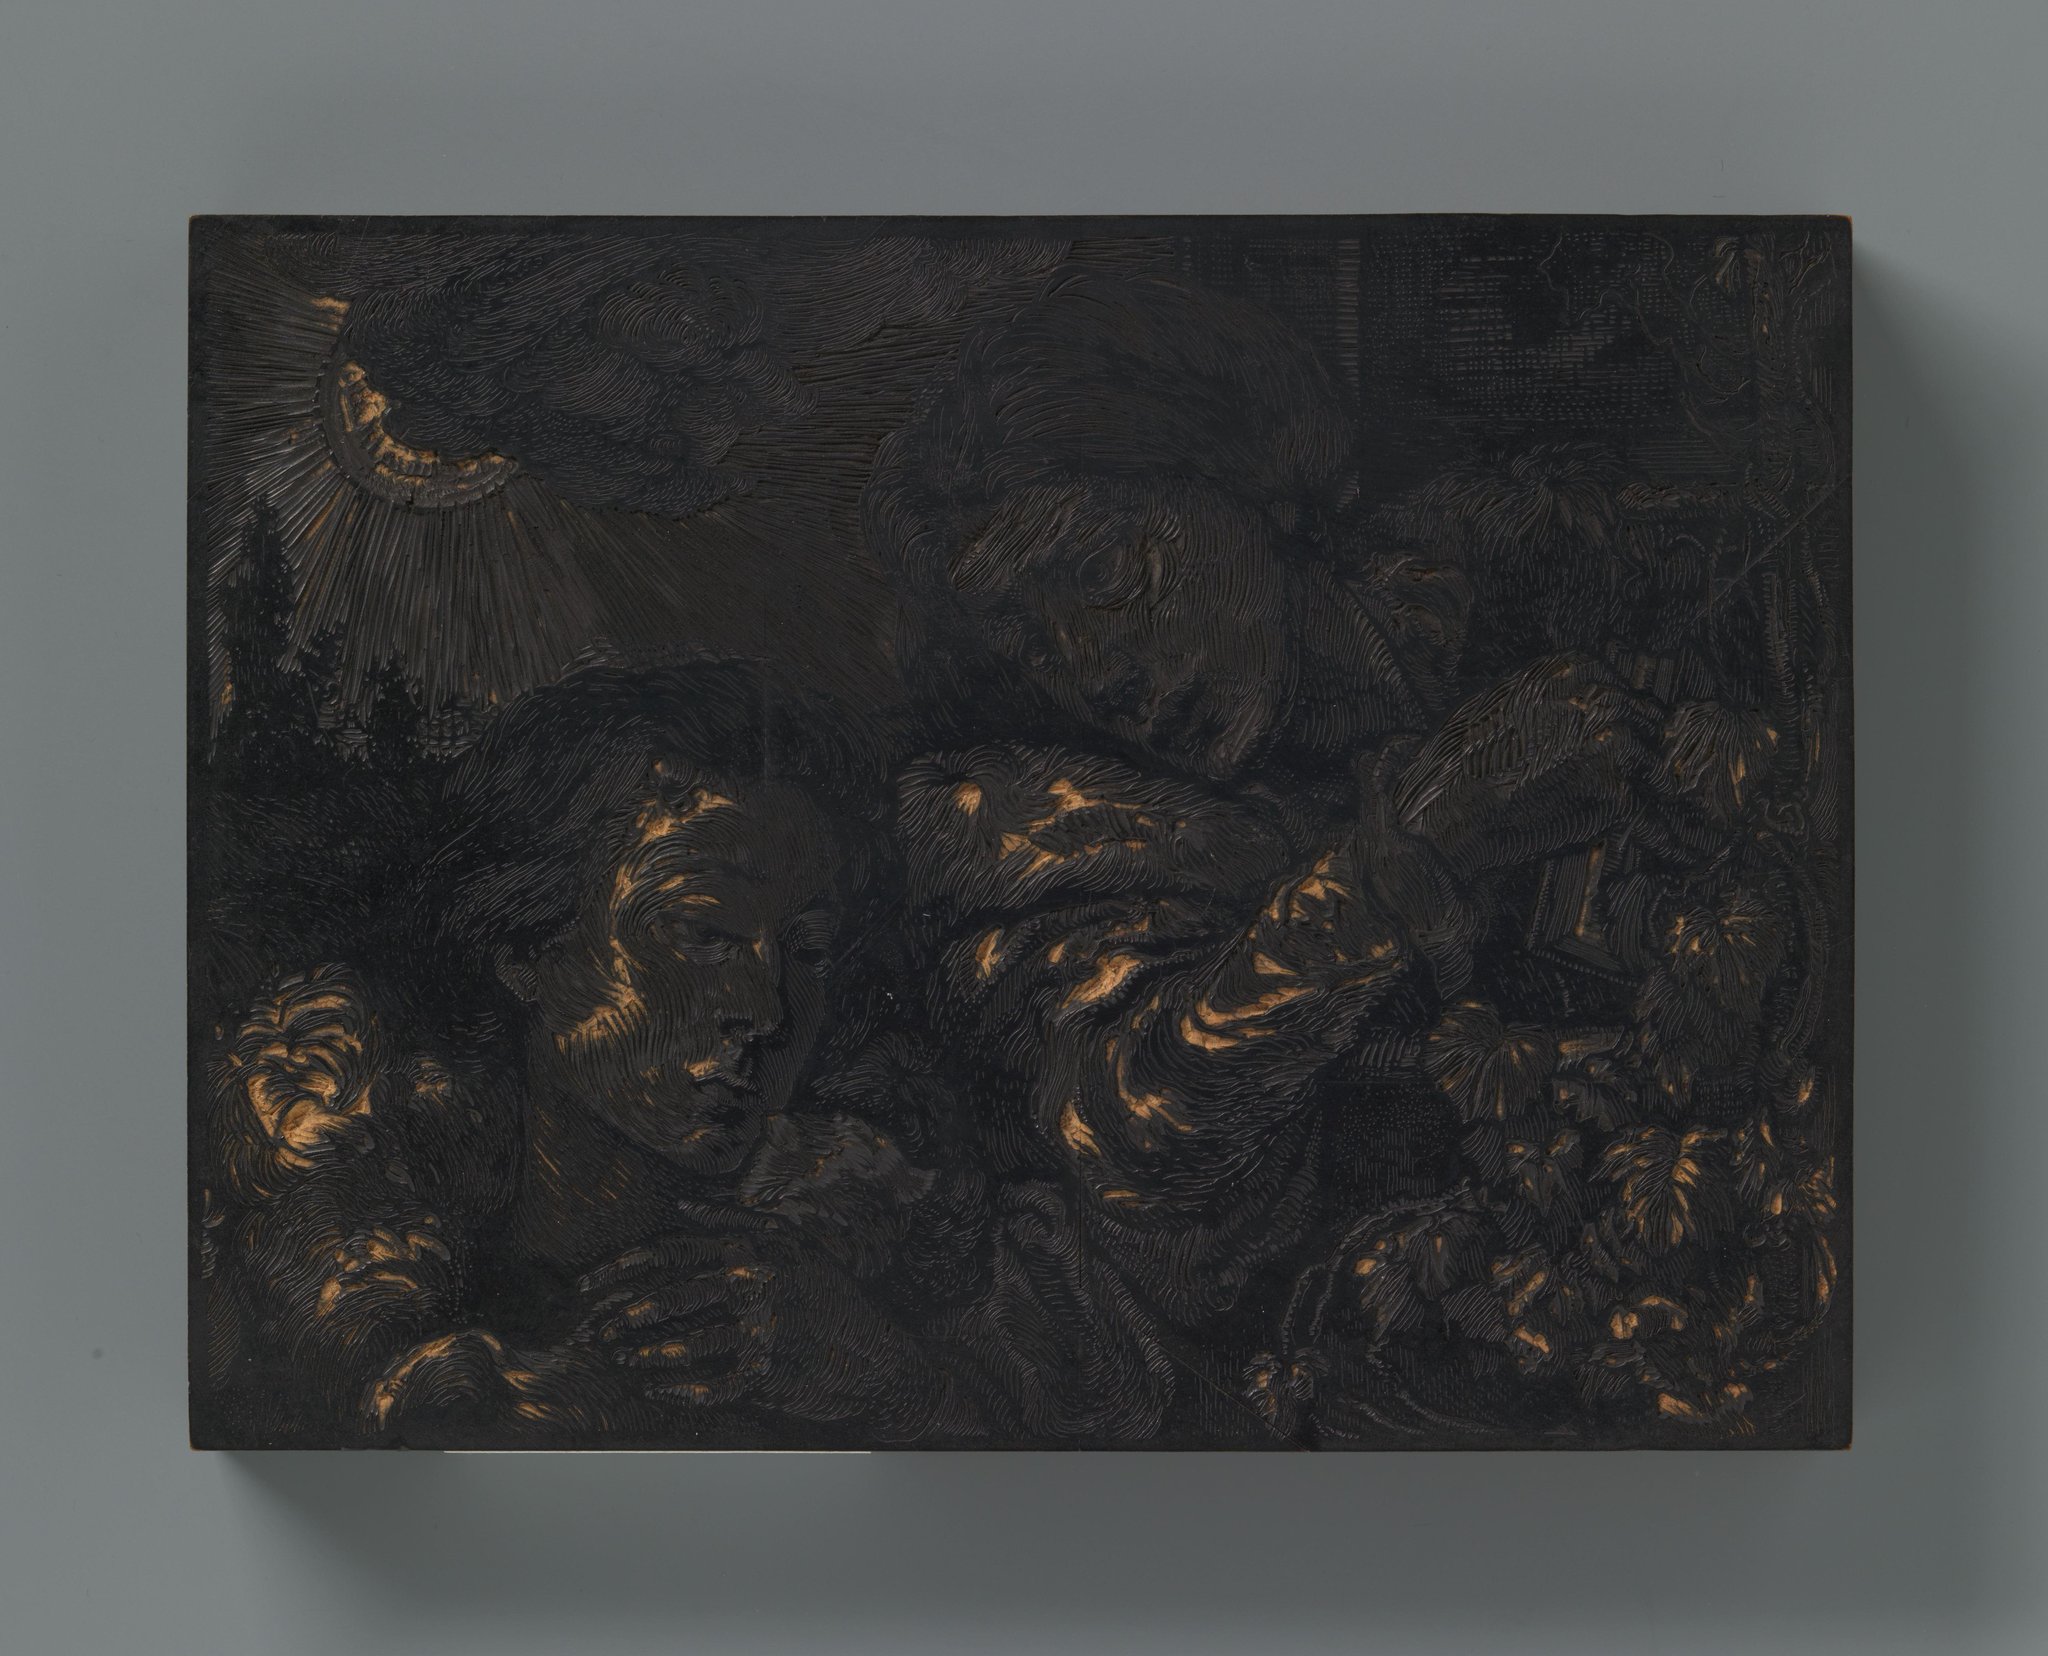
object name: wood block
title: Compositie met twee vrouwenkoppen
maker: johannes josephus aarts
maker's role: draughtsman, print maker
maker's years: 1871-1934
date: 1881-1934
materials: wood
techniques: woodcut